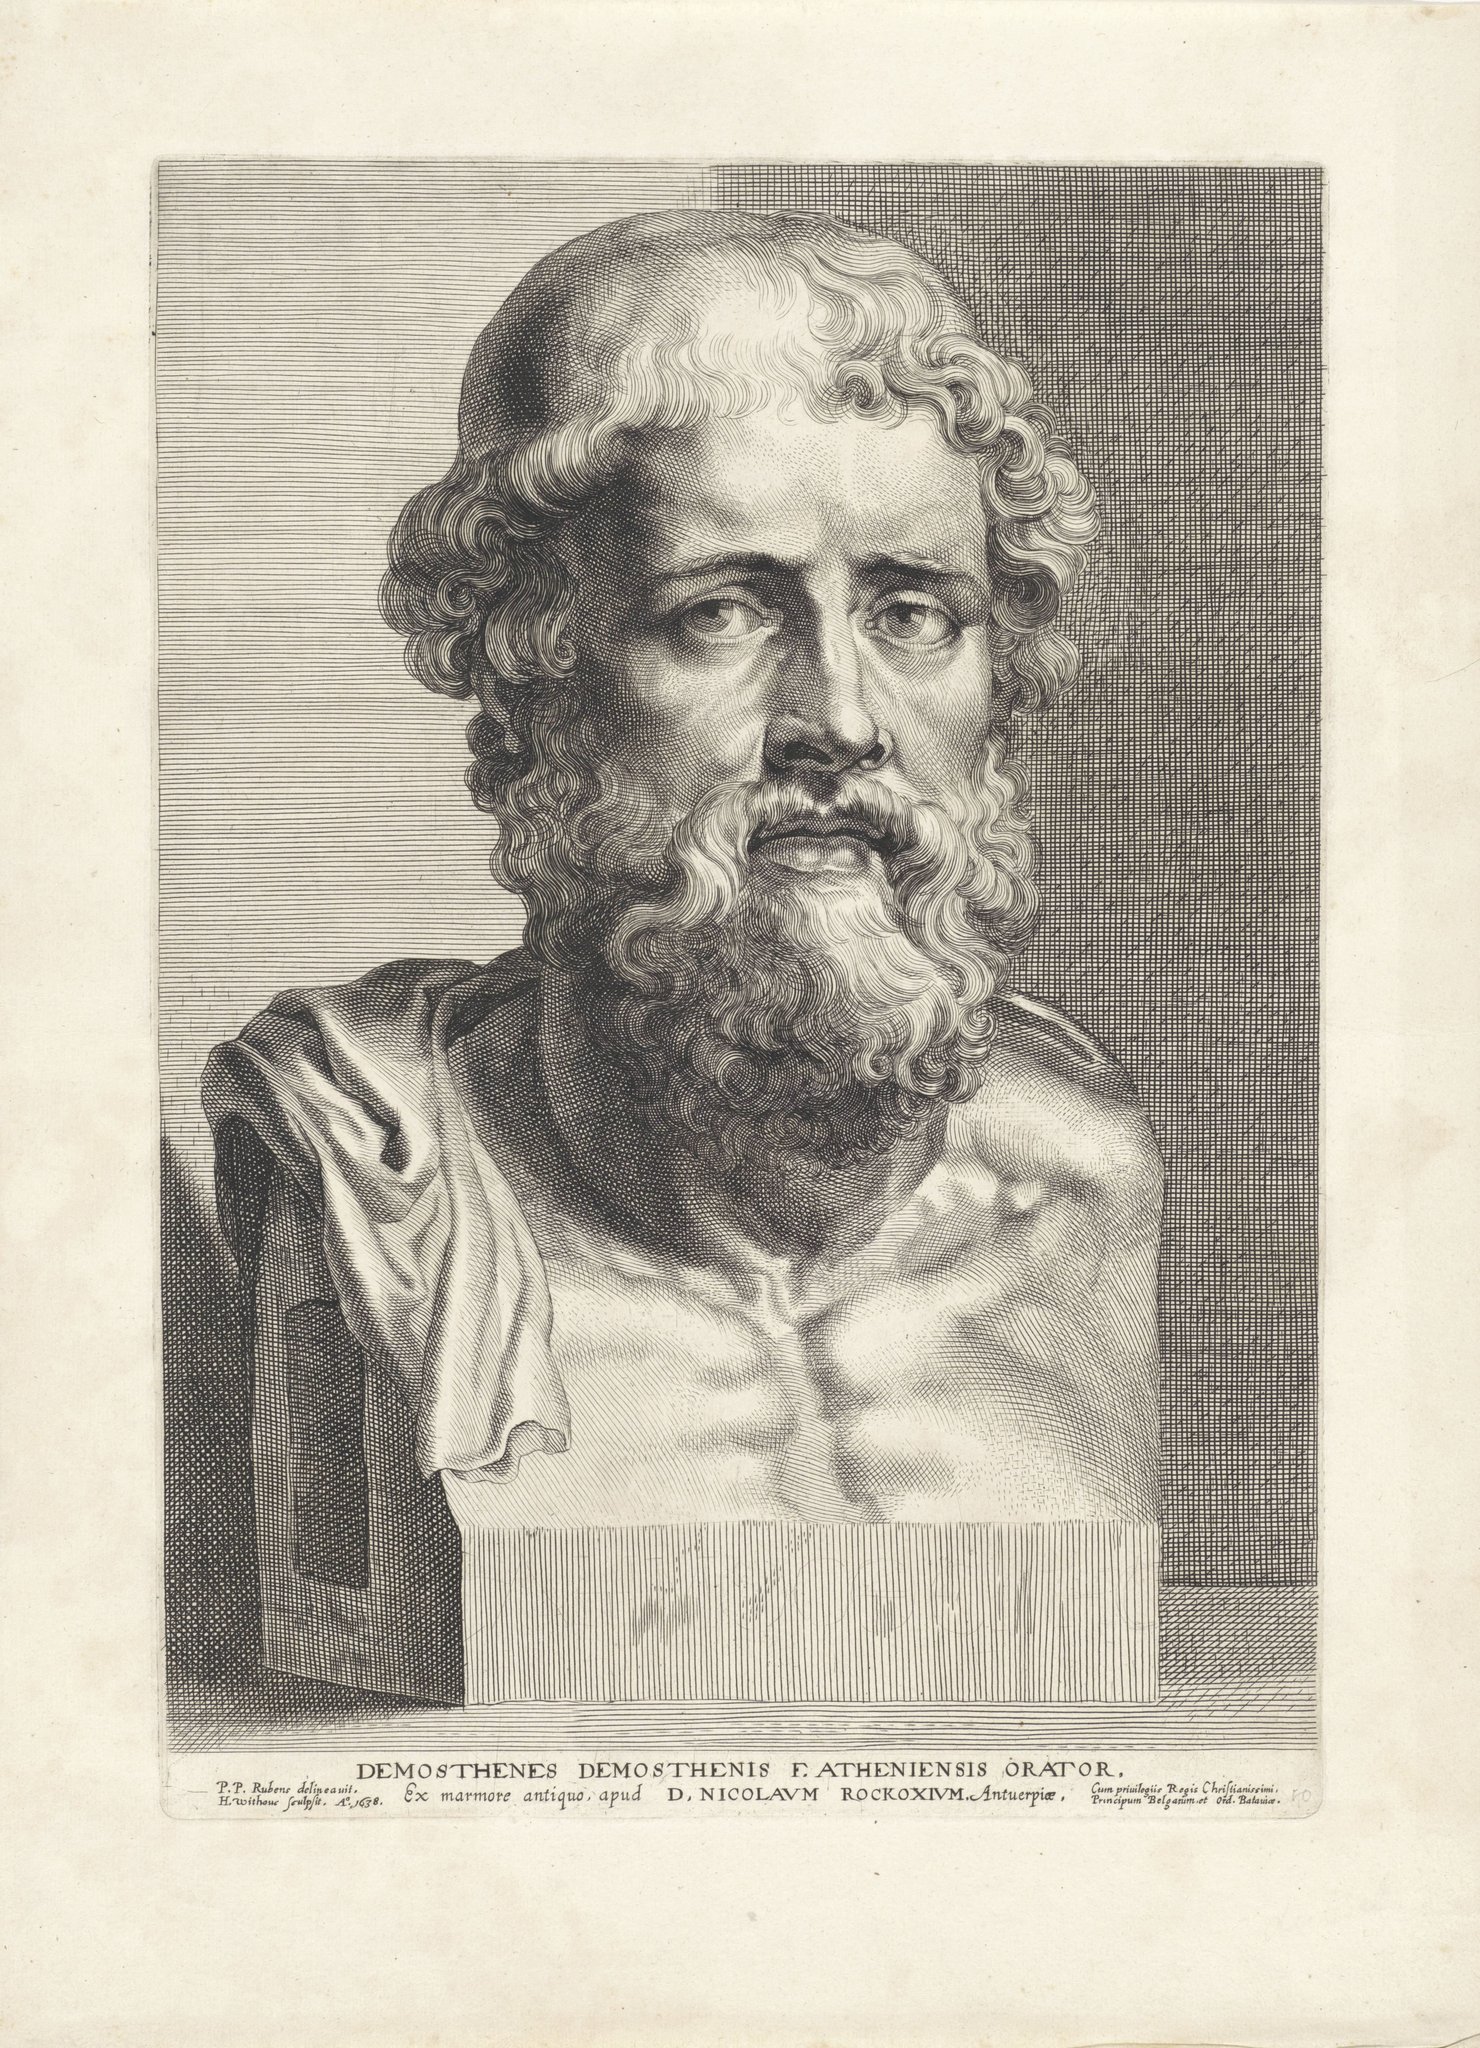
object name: print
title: Buste van Demosthenes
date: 1638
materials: paper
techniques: engraving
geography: antwerp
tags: jurist, redenaar, demosthenes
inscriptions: collector's mark: Lugt 240